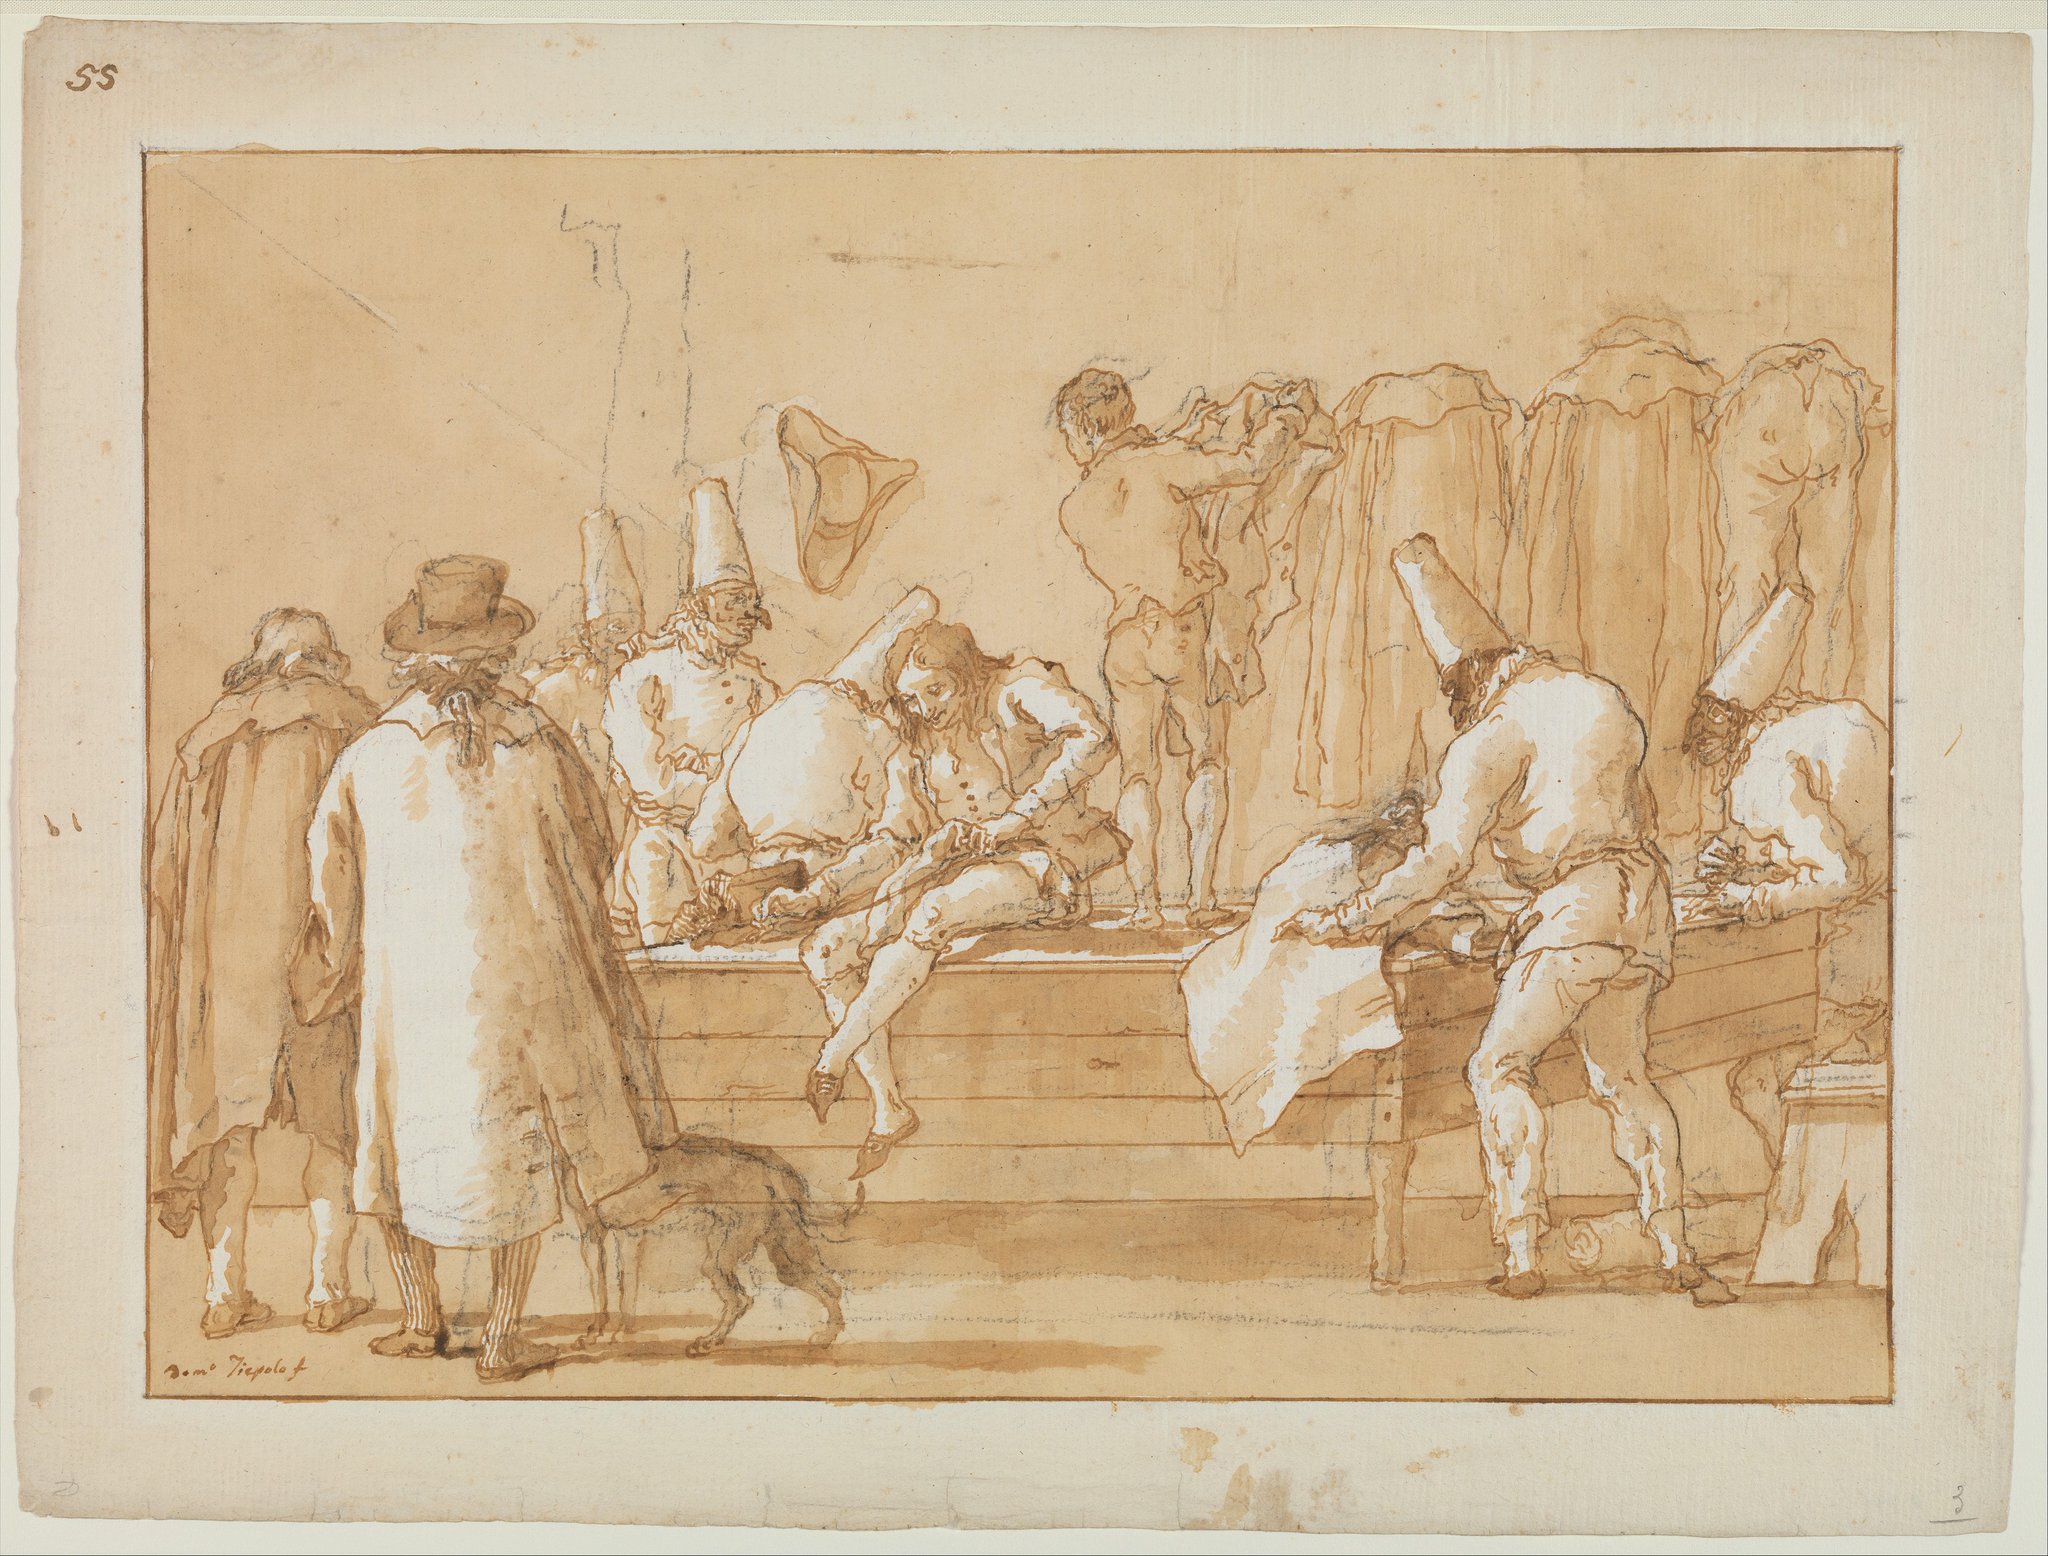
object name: drawing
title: Punchinello as Tailor's Assistant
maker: giovanni domenico tiepolo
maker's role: artist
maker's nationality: italian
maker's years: 1727-1804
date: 1767-1833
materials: chalk, ink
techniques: pen, wash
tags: men,sewing